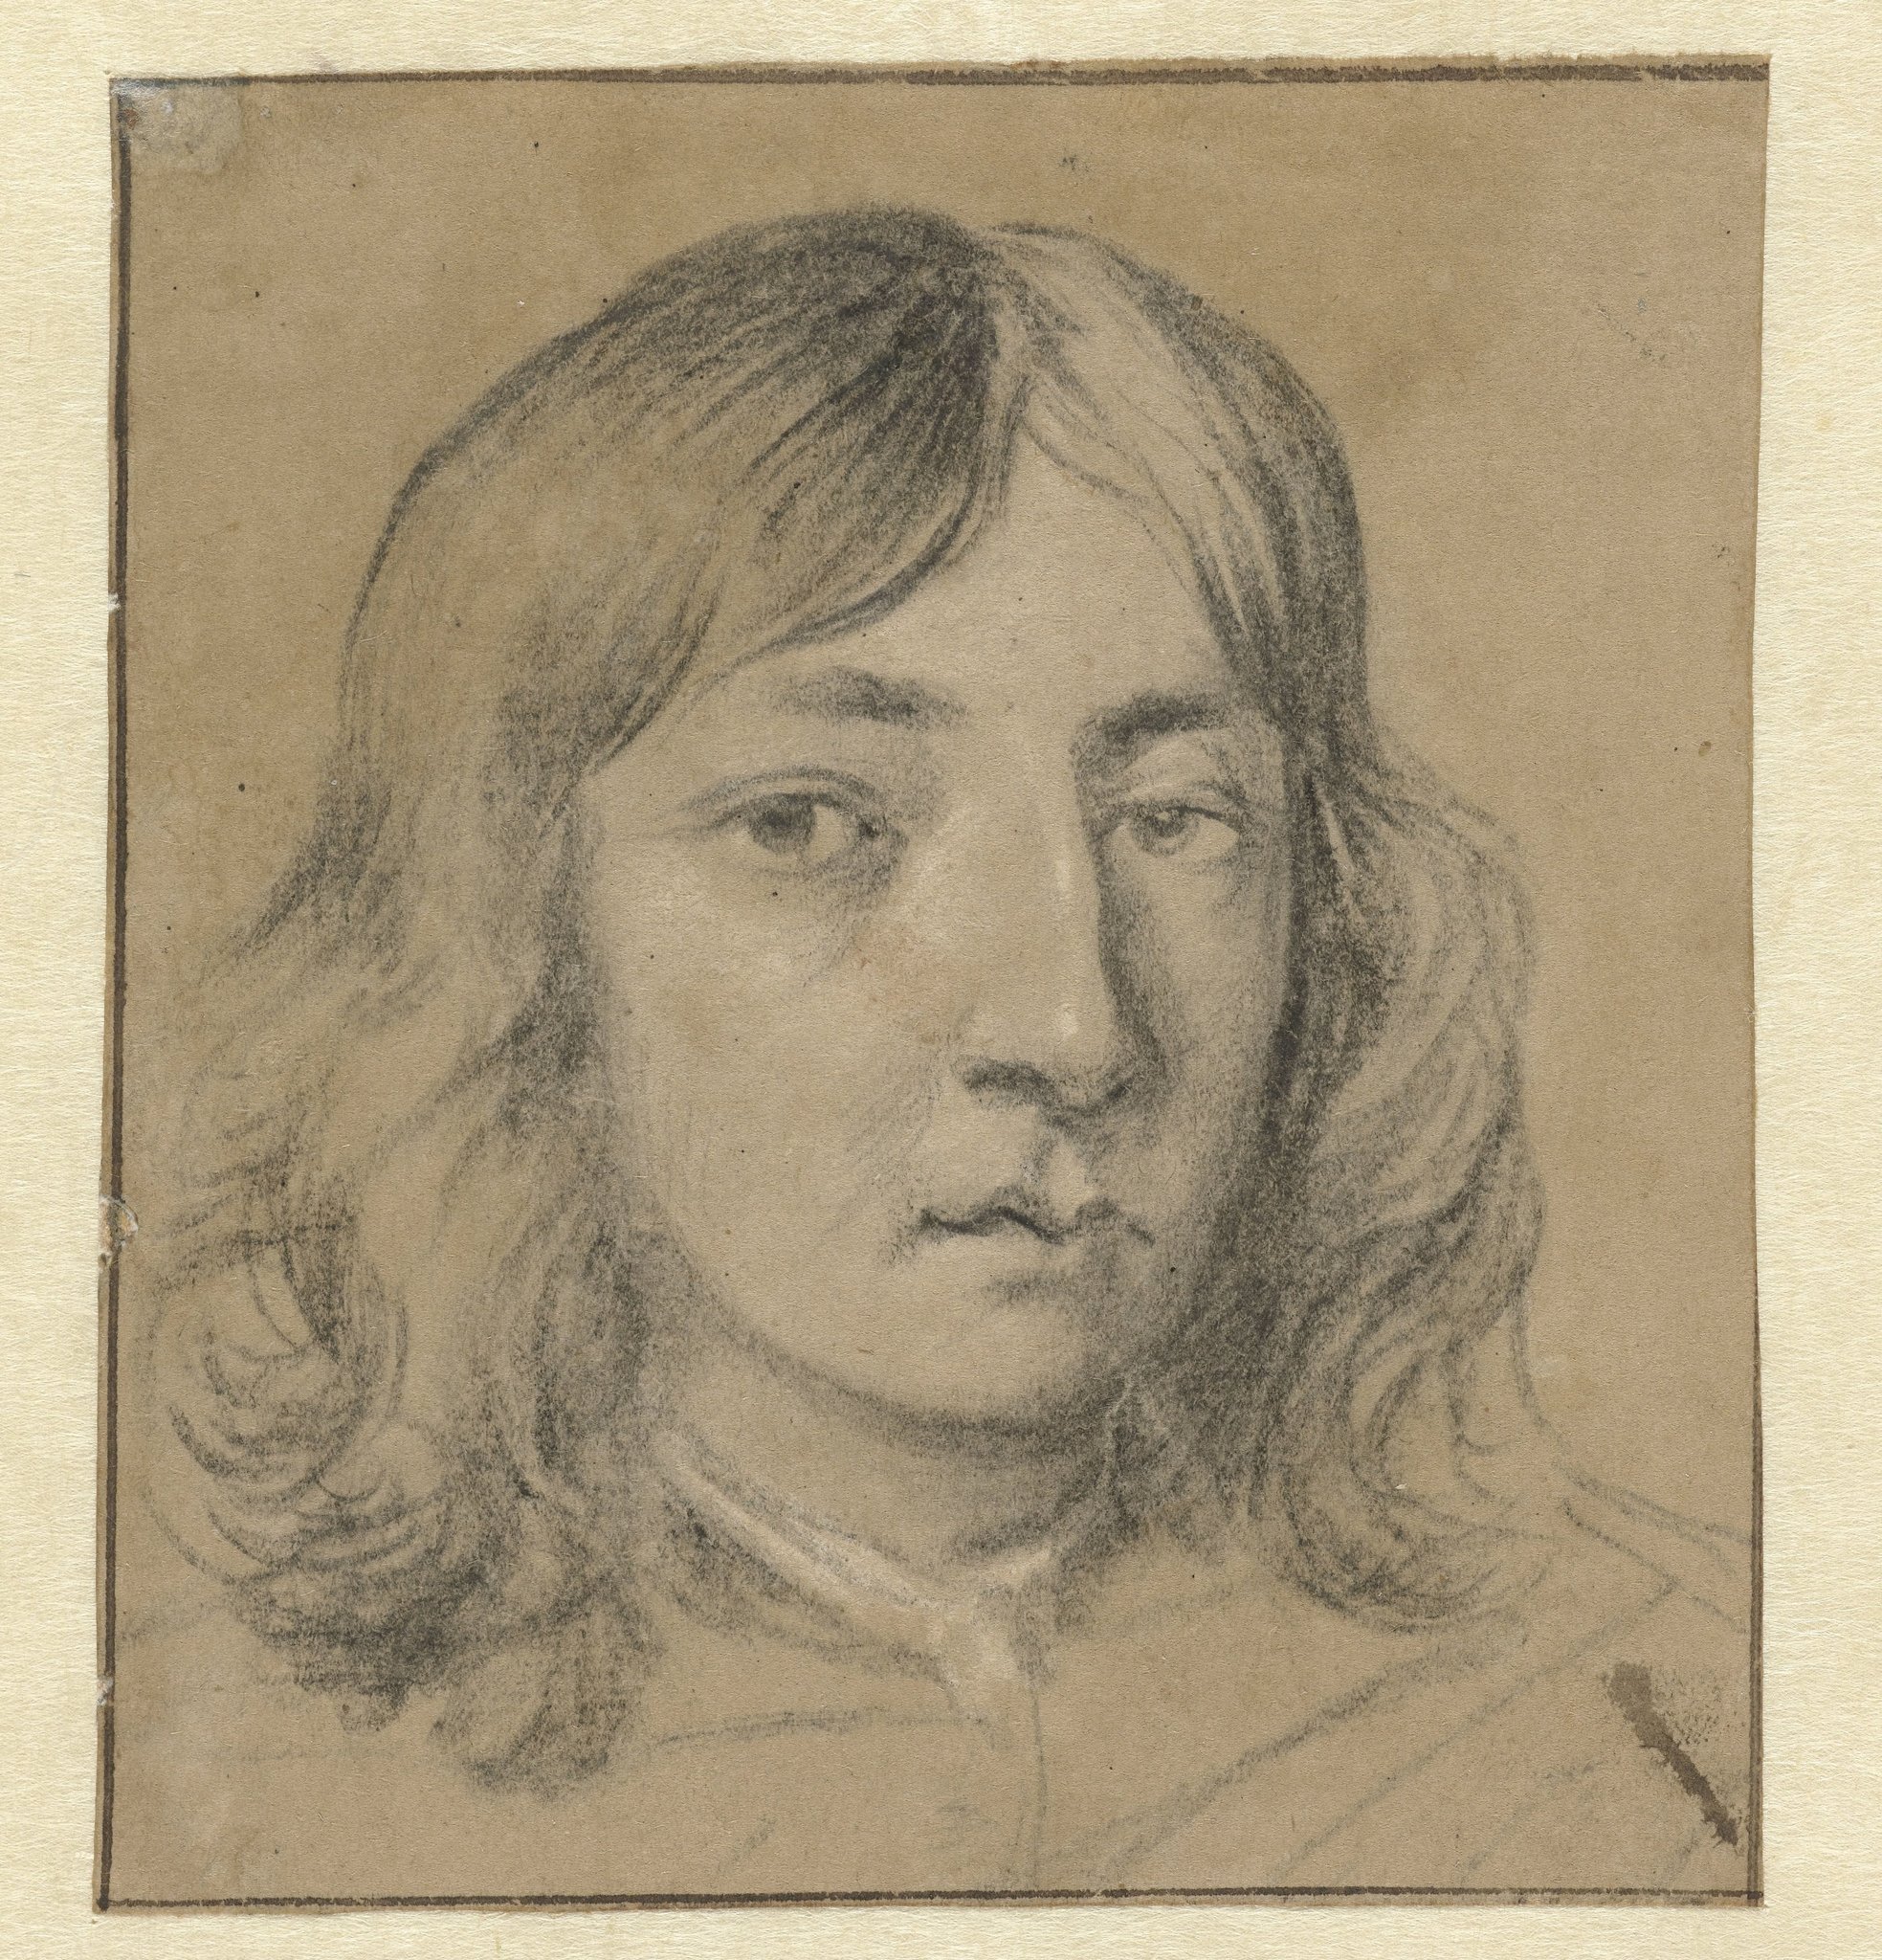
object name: drawing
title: Jongenskop met lang haar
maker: Anonymous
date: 1600-1699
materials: chalk, paper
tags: head (human), boy (child between toddler and youth)